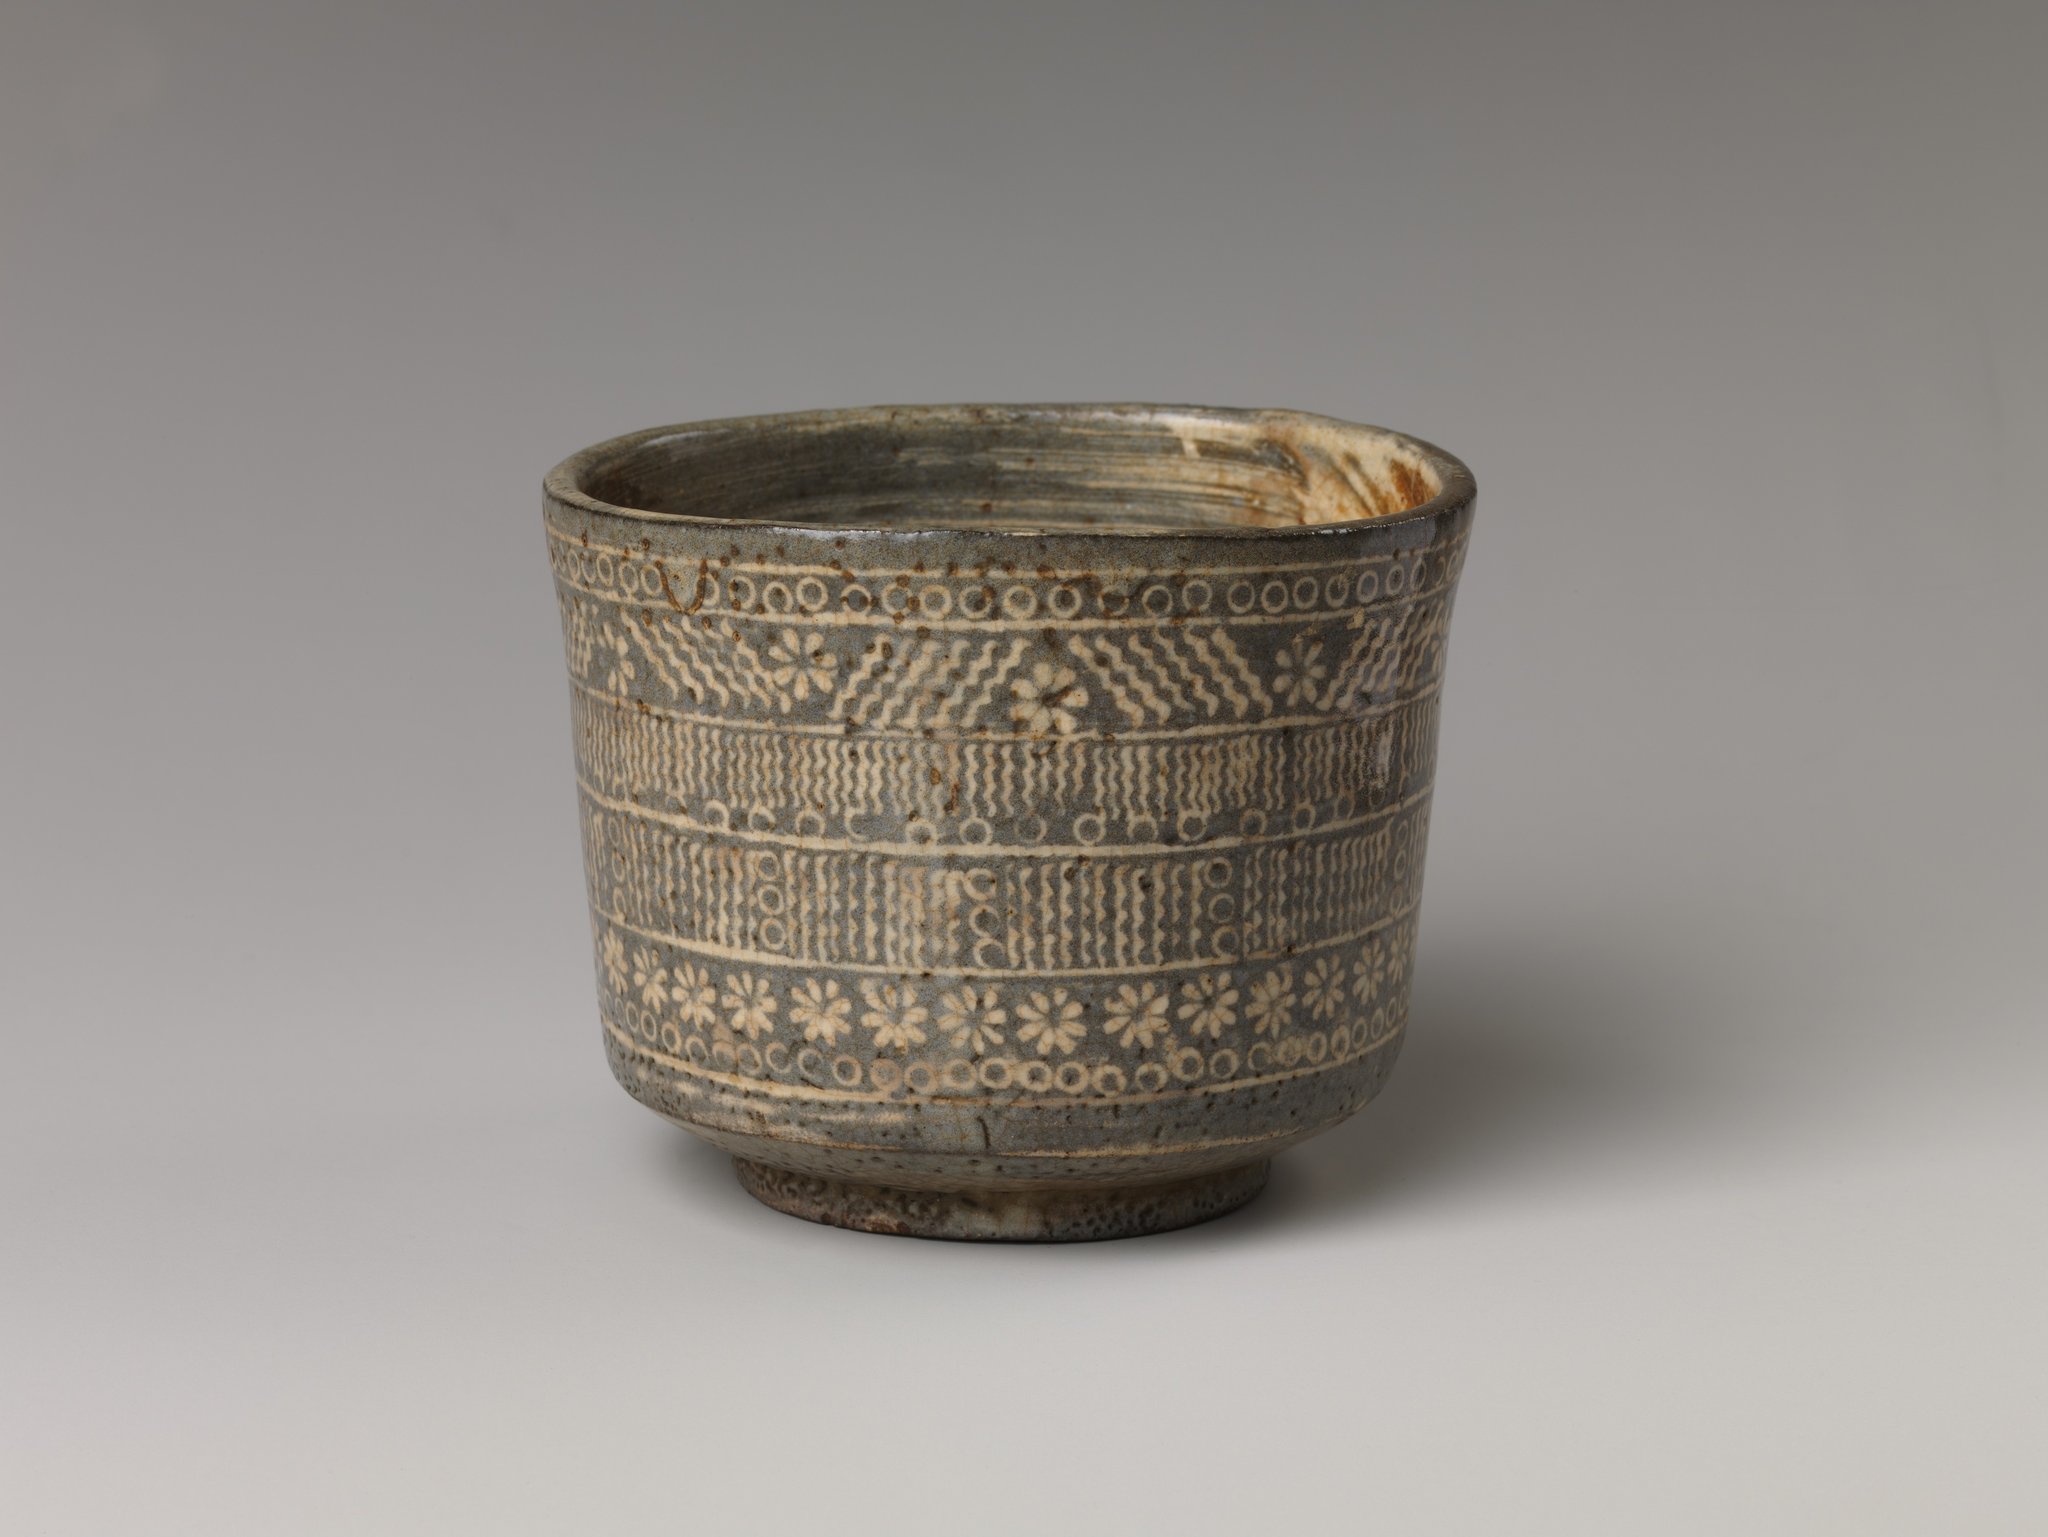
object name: teabowl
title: Tea bowl with decoration of chrysanthemums and wavy lines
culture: korean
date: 1601-1650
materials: stoneware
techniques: stamping